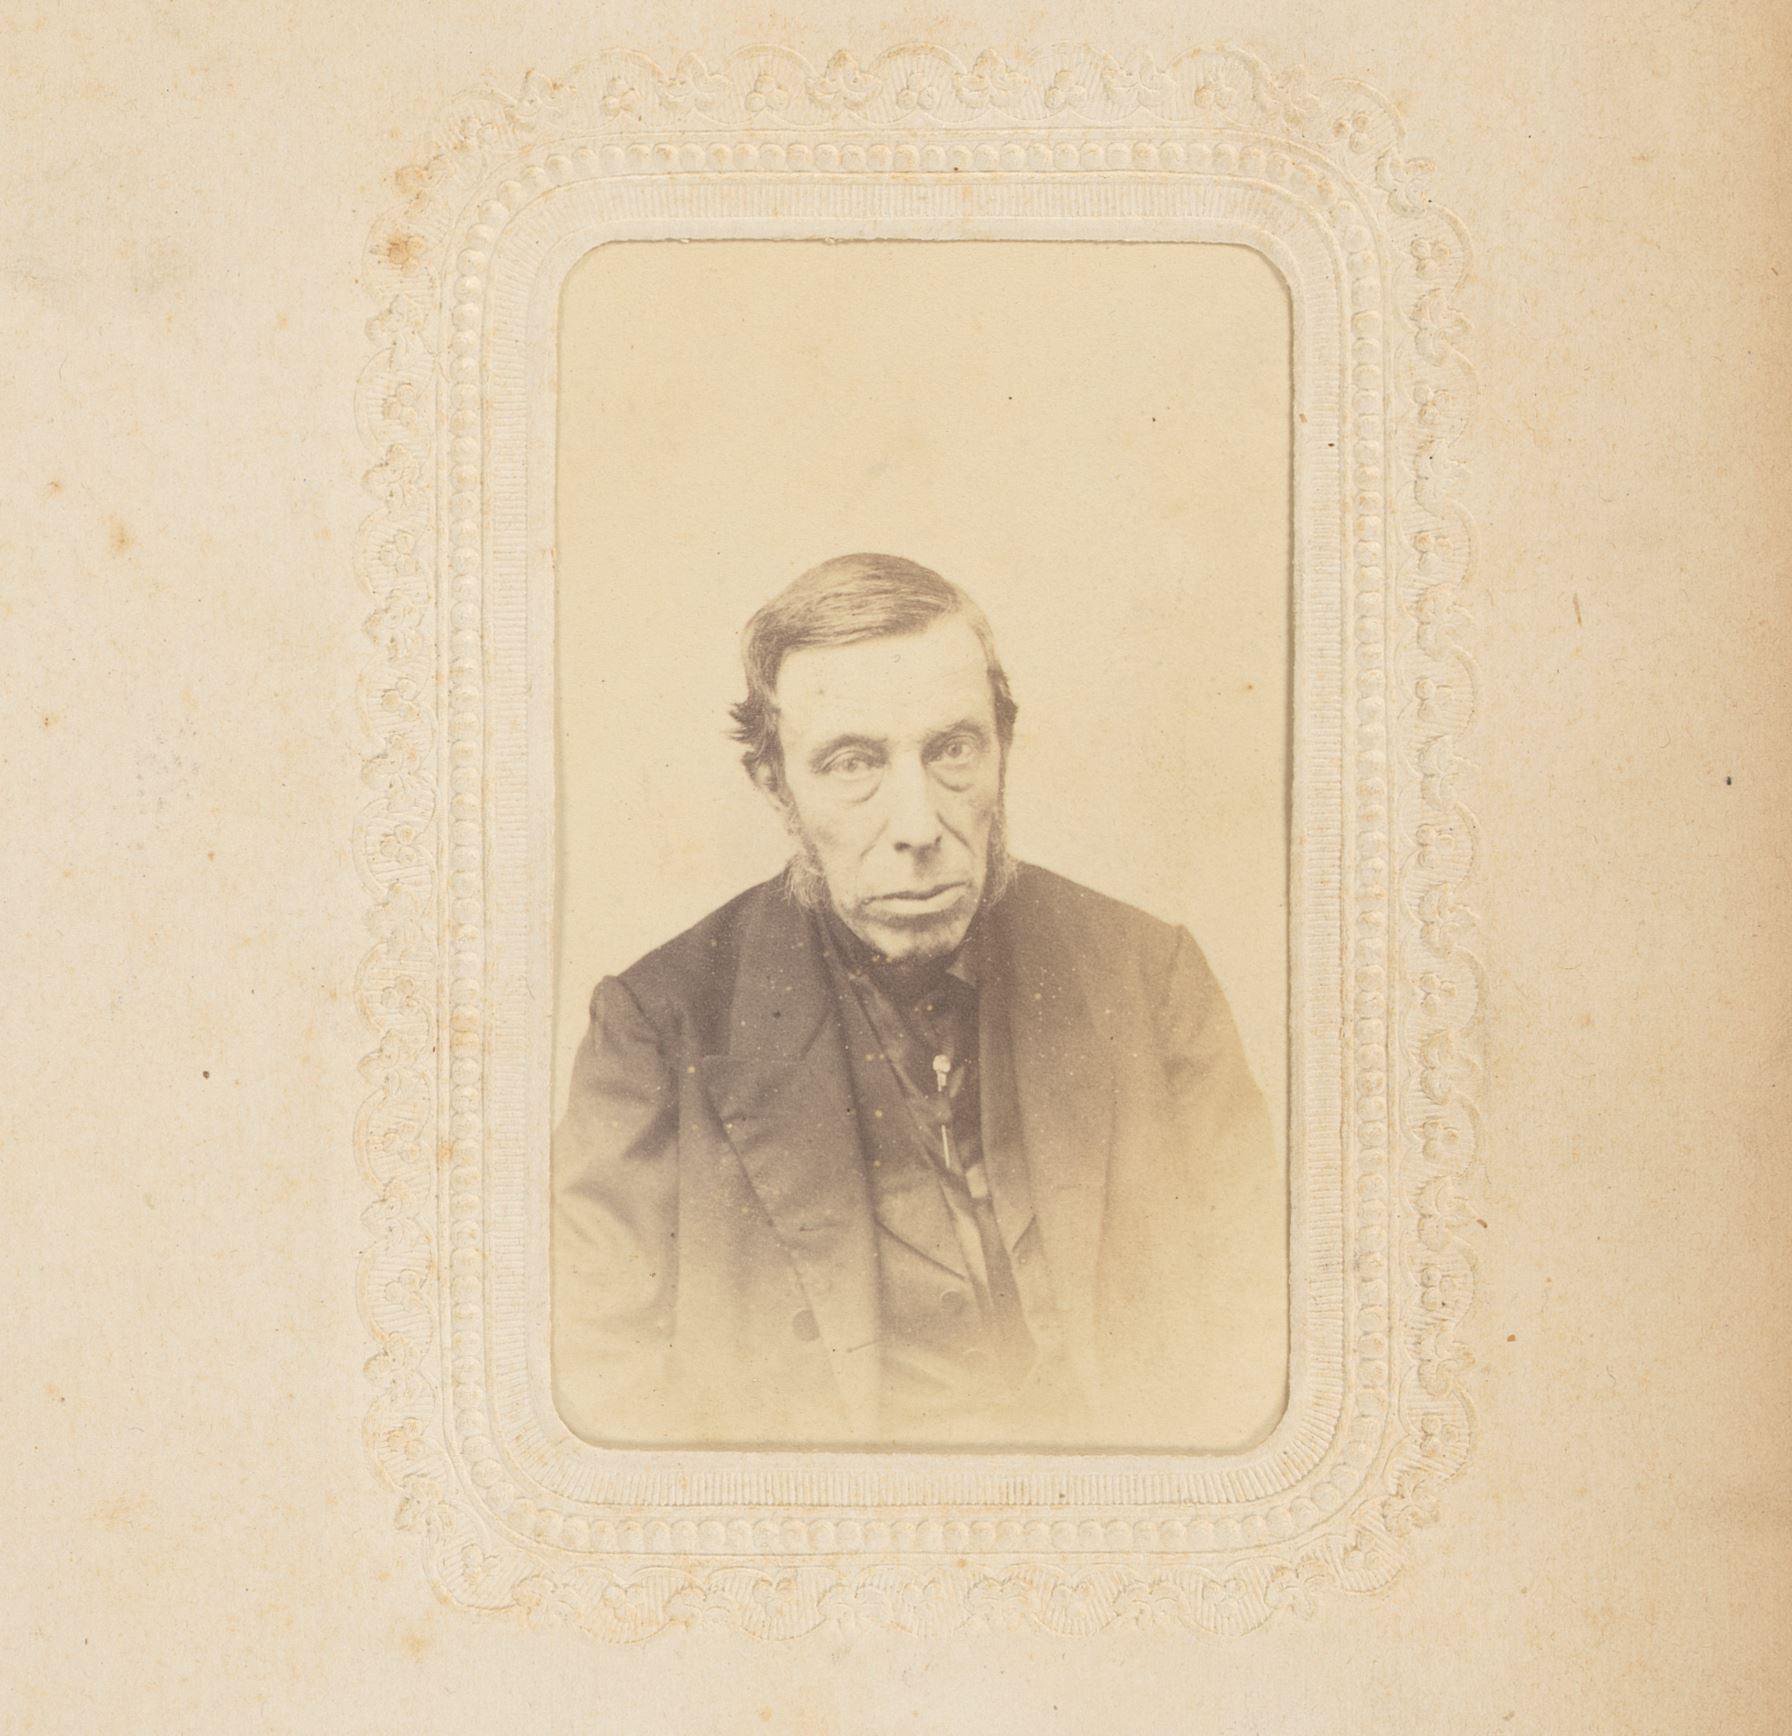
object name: photograph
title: Portret van een oude man met baard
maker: Anonymous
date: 1860-1890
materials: cardboard, photographic support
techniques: albumen print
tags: historical persons, beard